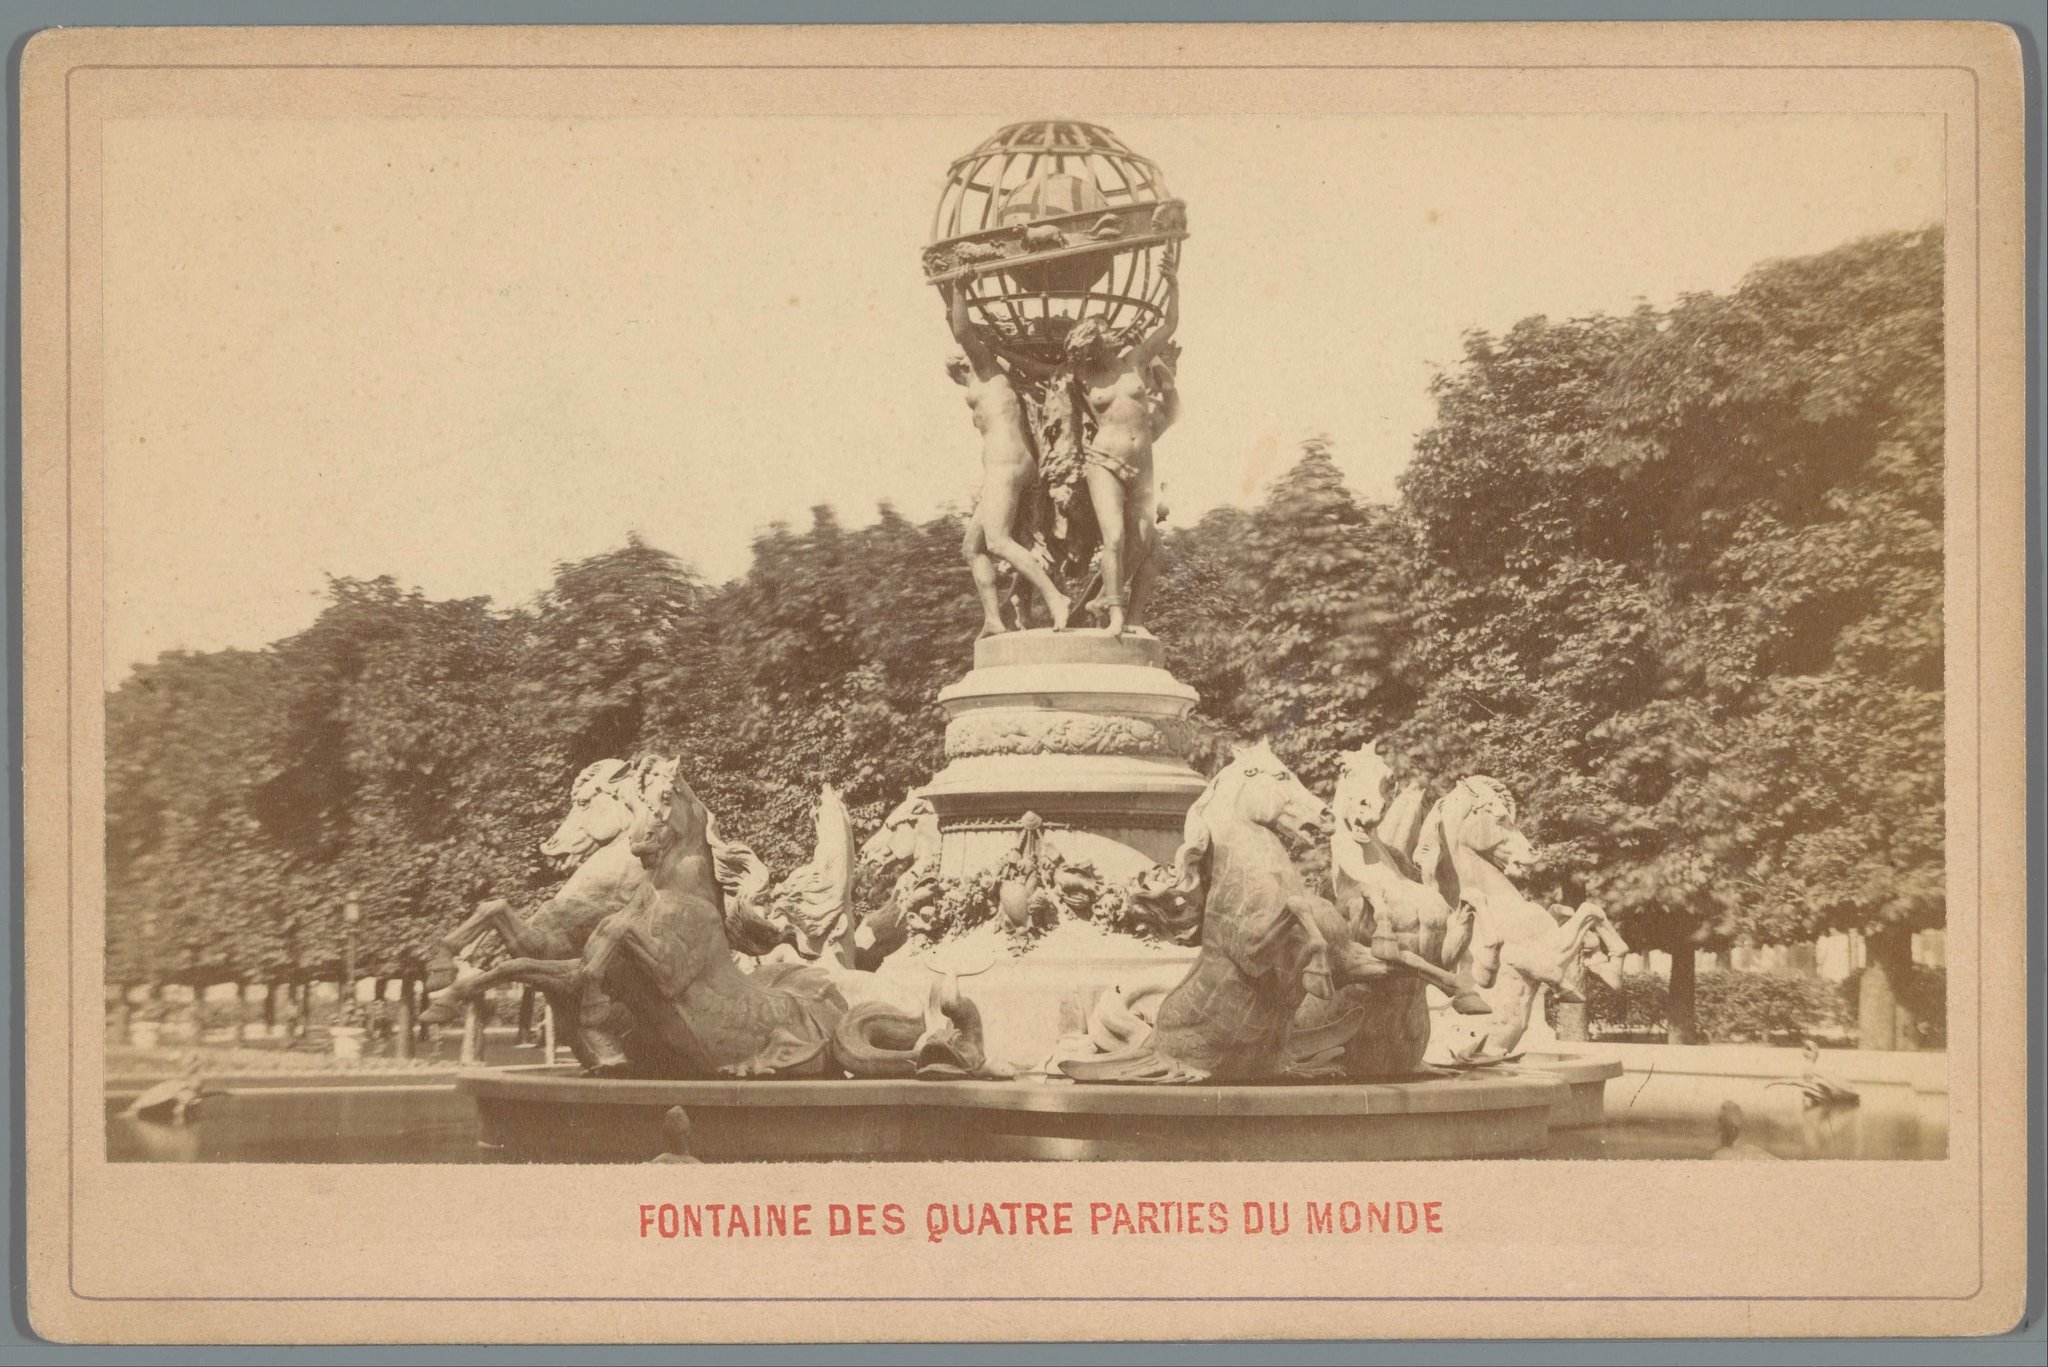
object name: cabinet photograph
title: Fontaine des Quatre Parties du Monde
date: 1874-1890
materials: cardboard, paper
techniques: albumen print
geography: paris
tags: ornamental fountain, public gardens, park